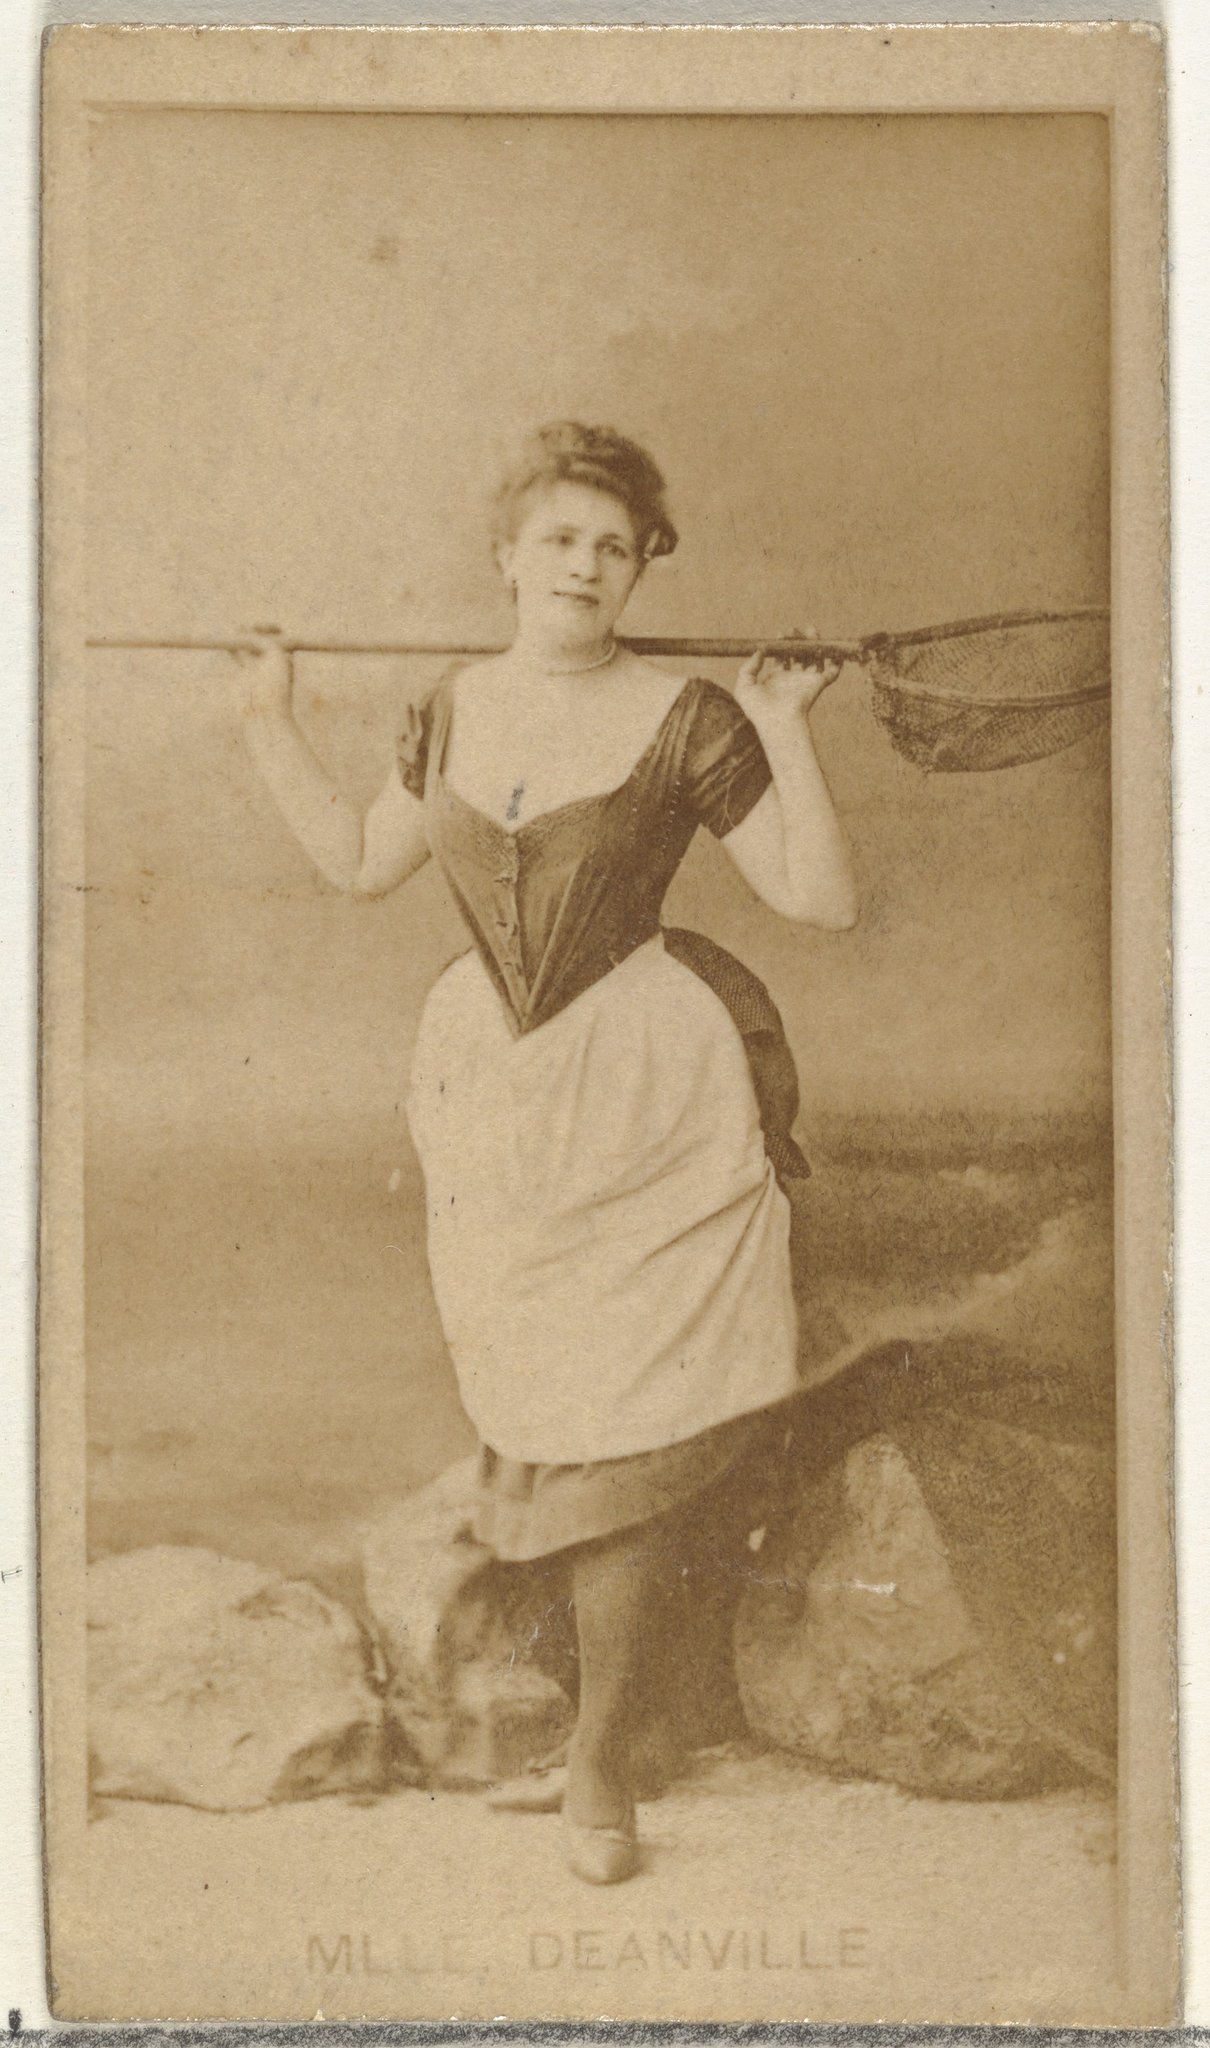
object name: photograph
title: Mlle. Deanville, from the Actors and Actresses series (N145-8) issued by Duke Sons & Co. to promote Duke Cigarettes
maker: w. duke, sons & co.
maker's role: publisher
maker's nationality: american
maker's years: 1870-1920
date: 1891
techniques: albumen silver print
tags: portraits,women,actresses